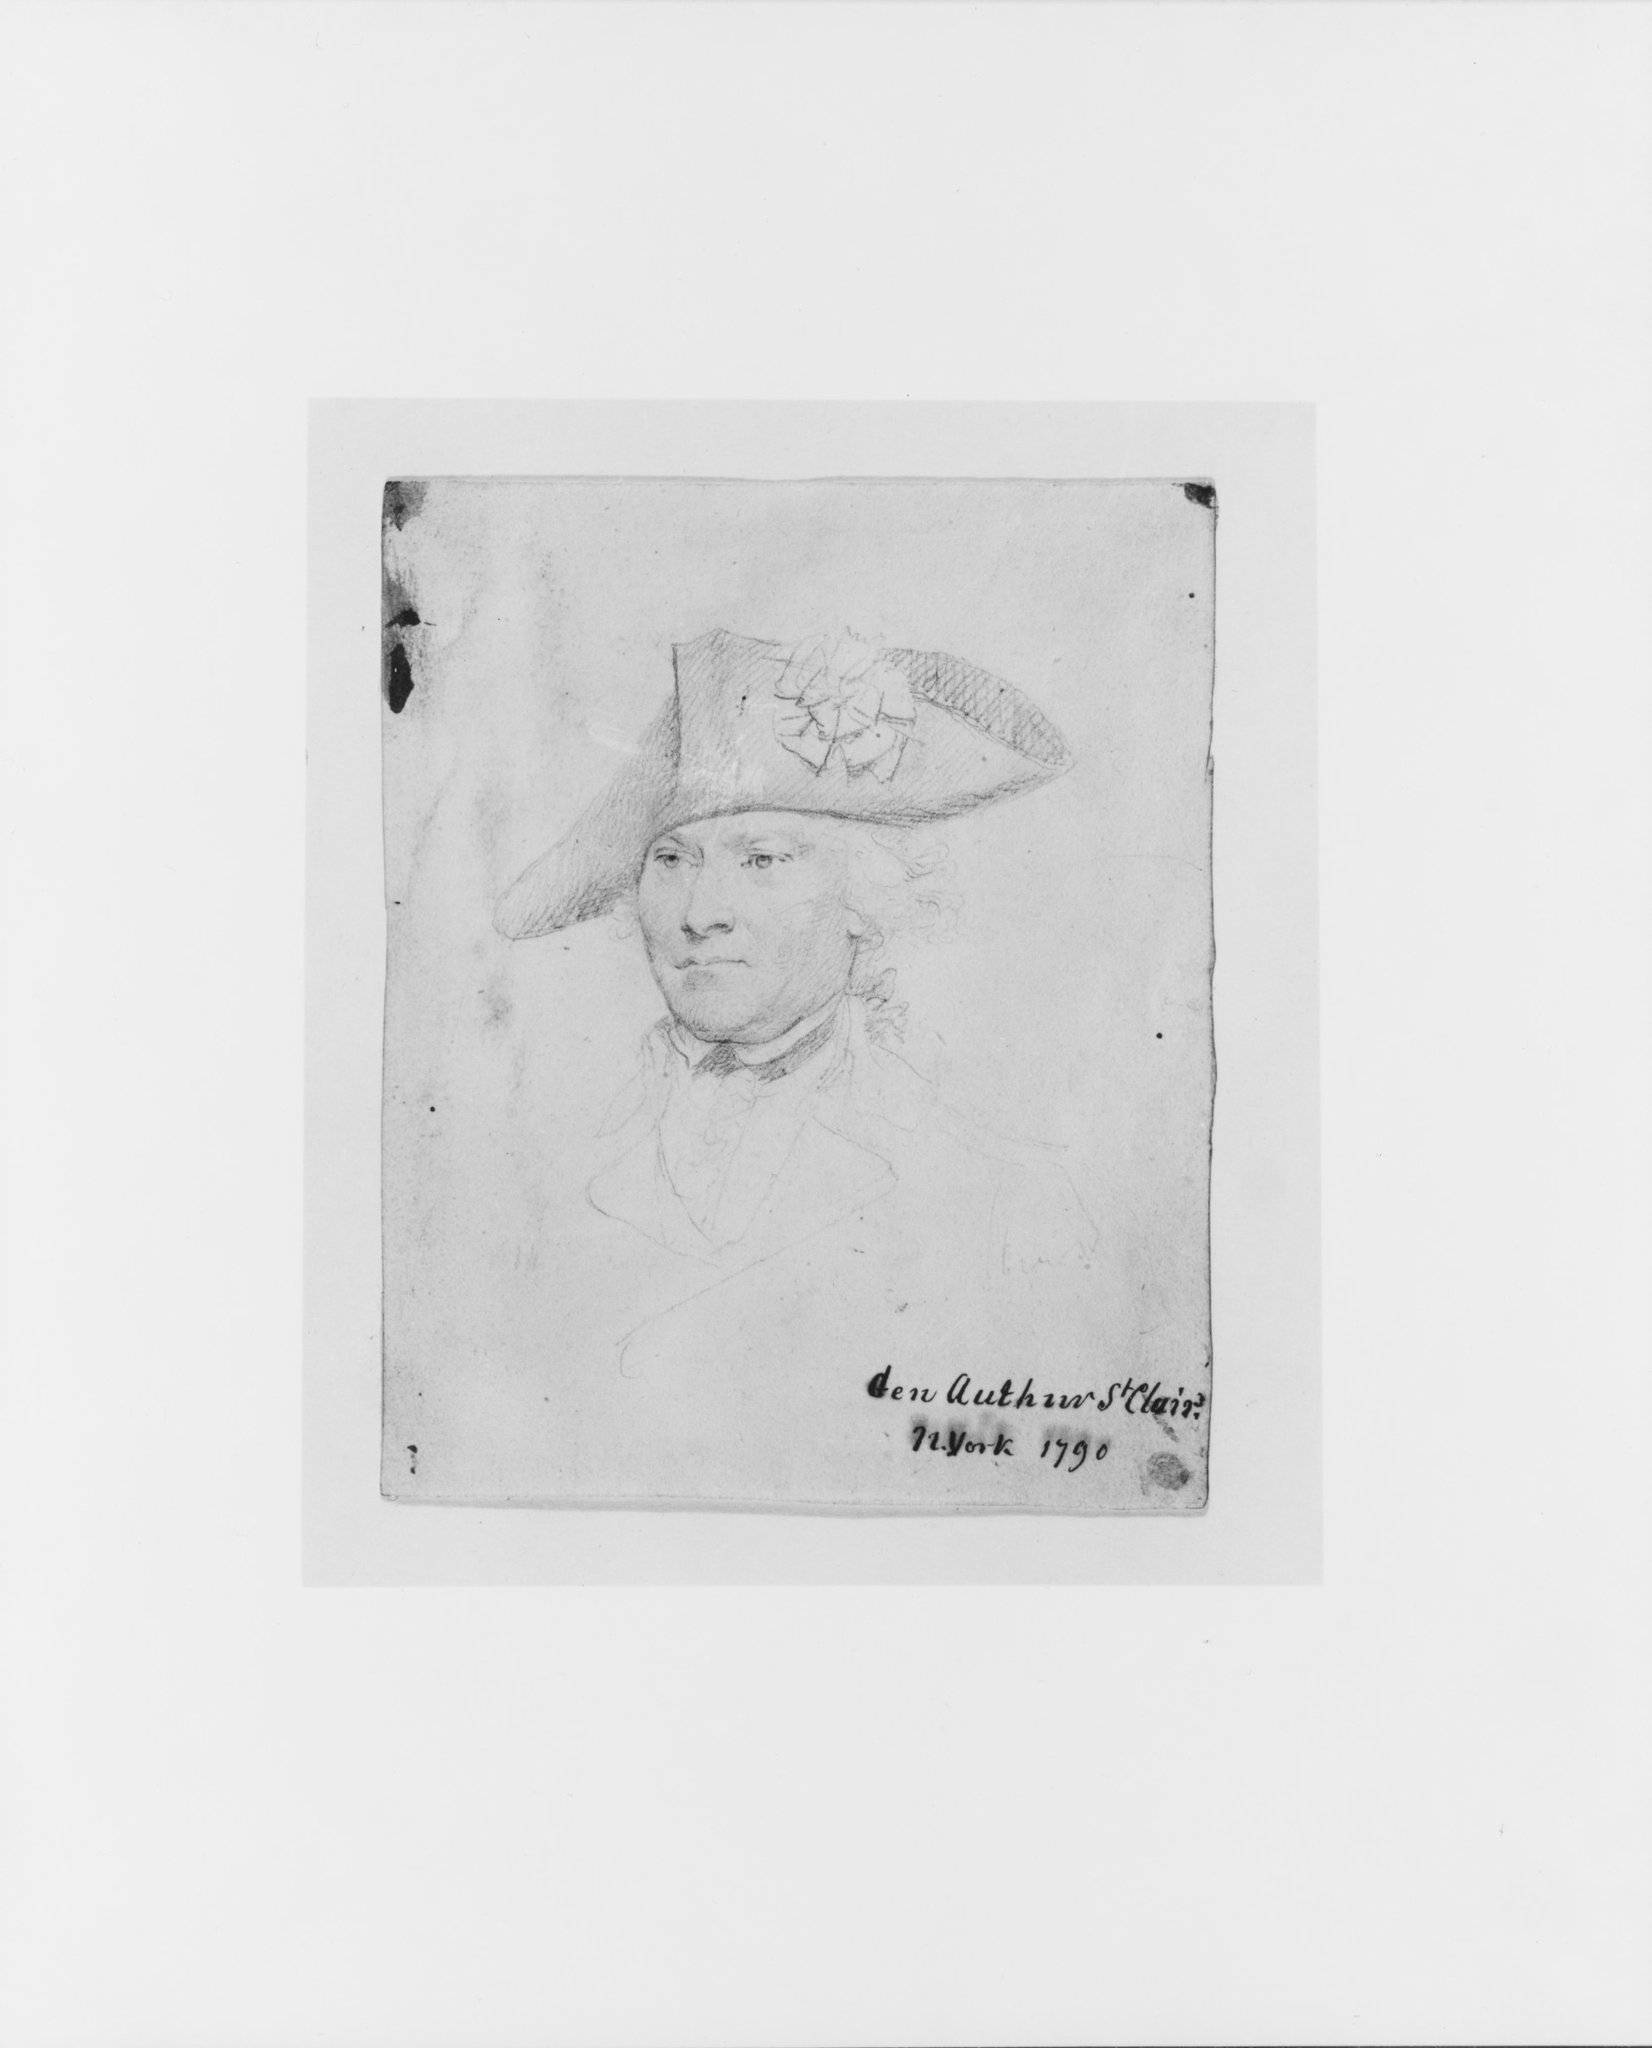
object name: drawing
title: General Arthur St. Clair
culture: american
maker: john trumbull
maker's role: artist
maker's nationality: american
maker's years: 1756-1843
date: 1790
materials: graphite, paper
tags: men,portraits,generals